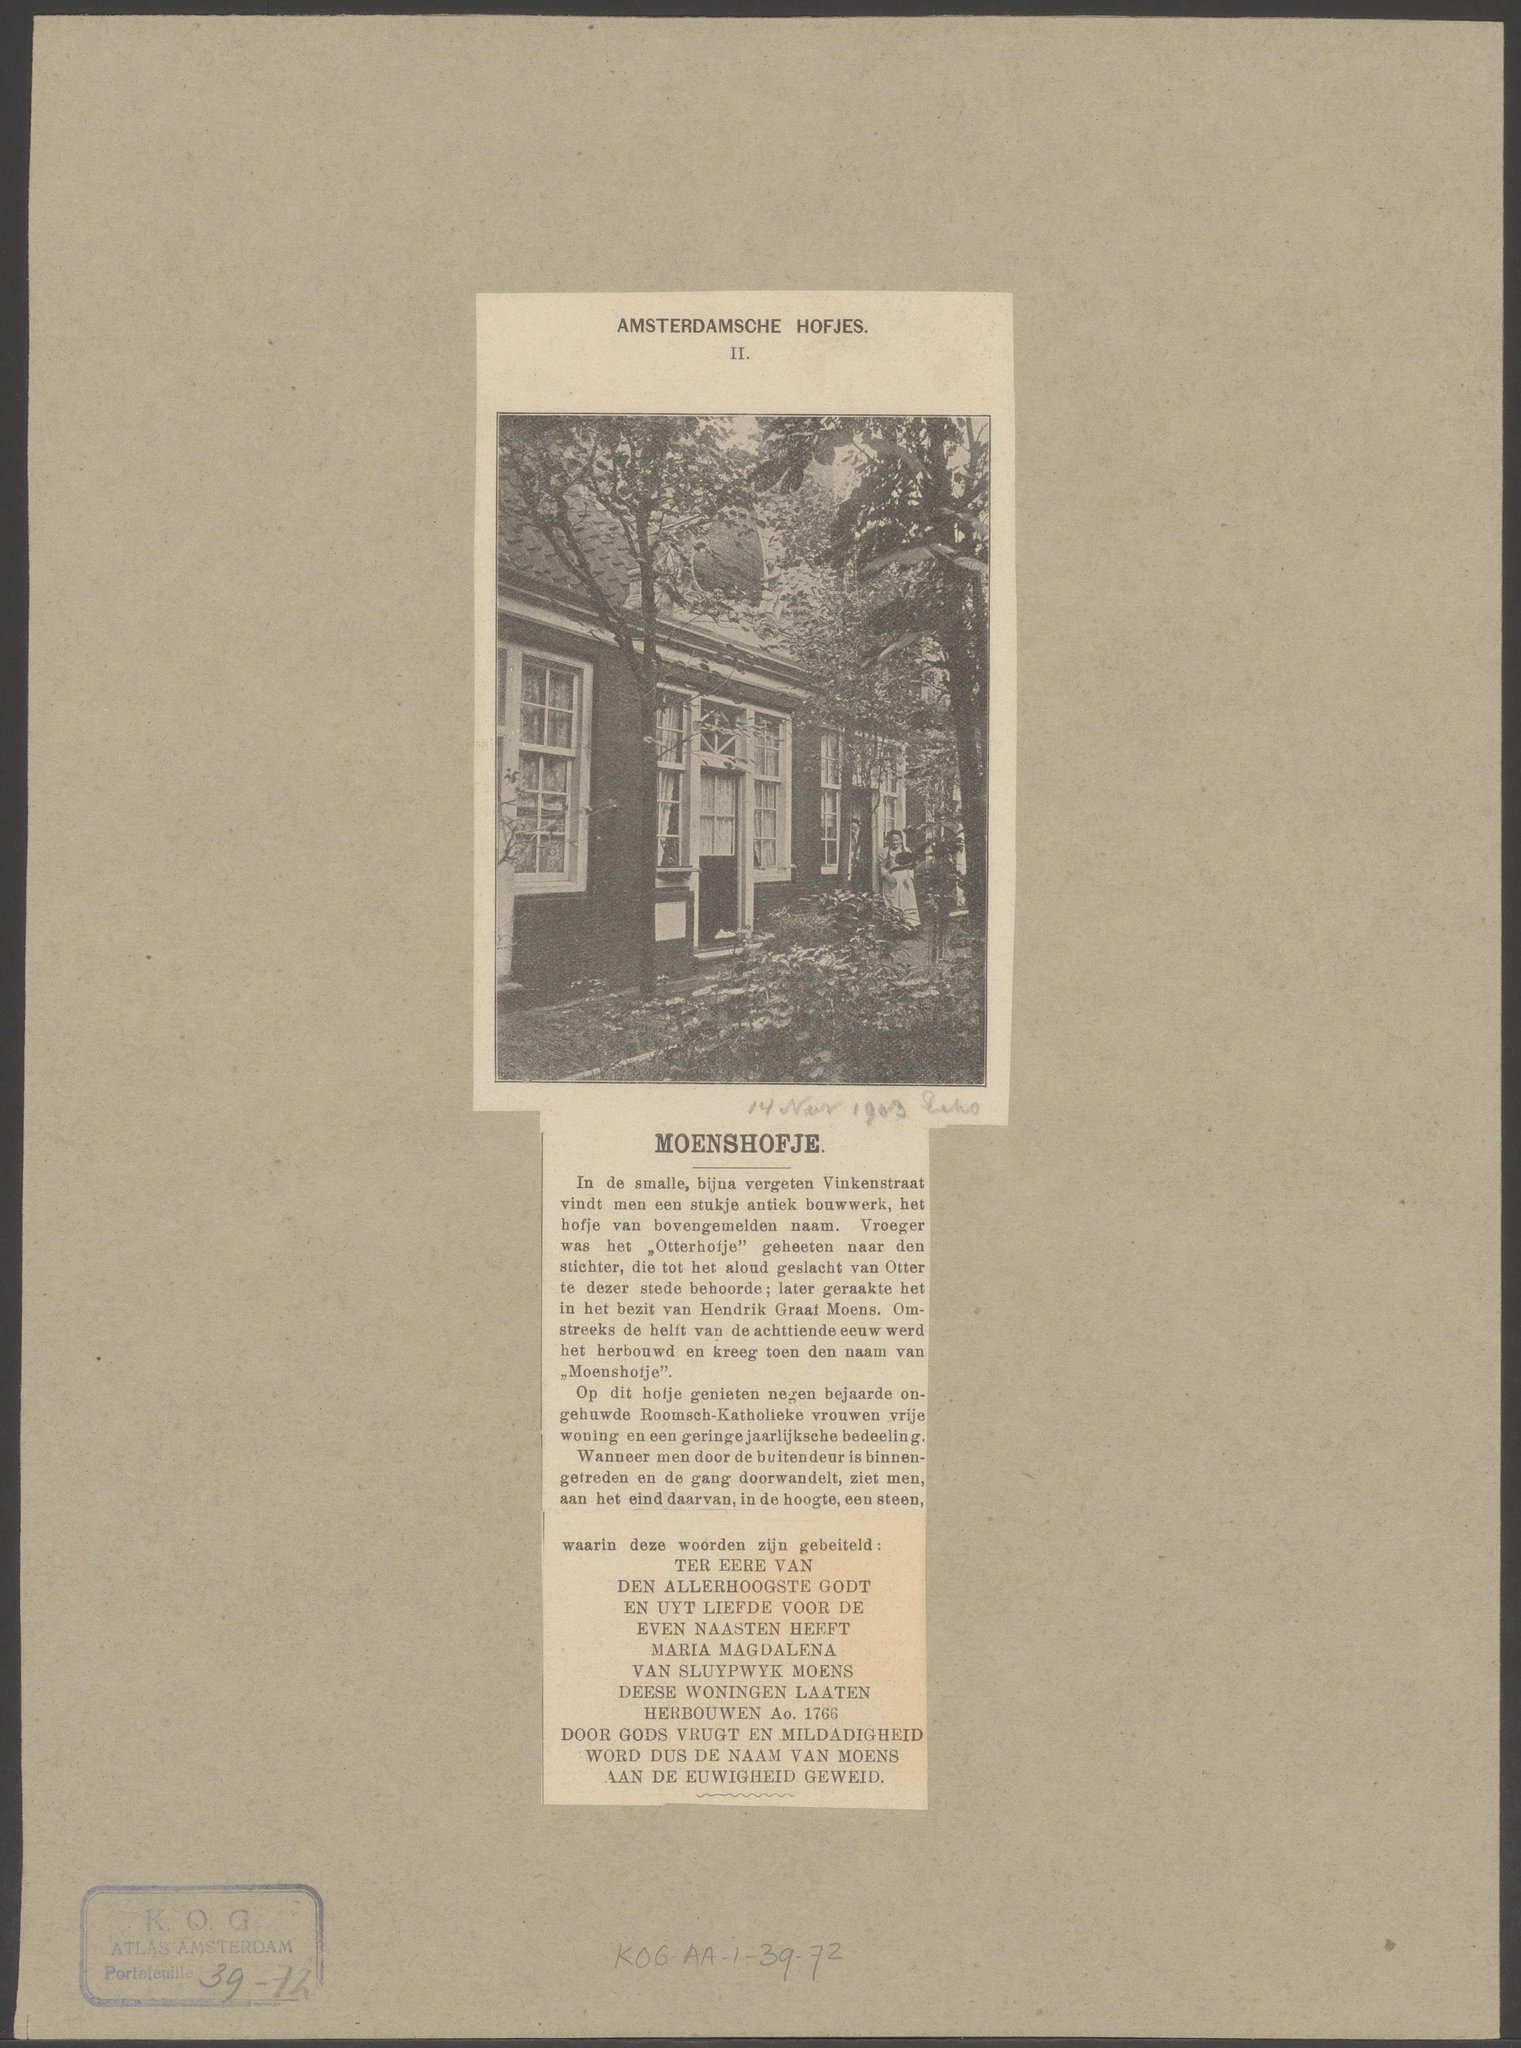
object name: photomechanical print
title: Amsterdamsche Hofjes. II / Moenshofje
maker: Anonymous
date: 1903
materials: paper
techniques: letterpress printing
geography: netherlands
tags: alms-house (dutch: 'hofje'), courtyard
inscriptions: collector's mark: Lugt 1641b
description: Object bestaat uit twee aan elkaar geplakte bladen. Onderwerpsrubriek binnen de Atlas Amsterdam: Armwezen en liefdadige instellingen: III. Verschillende gestichten en instellingen / Hofjes: Lindenhofje - Looiershofje - Moens- of Ottershofje - Protestantsch Weduwen en Wezenfonds.